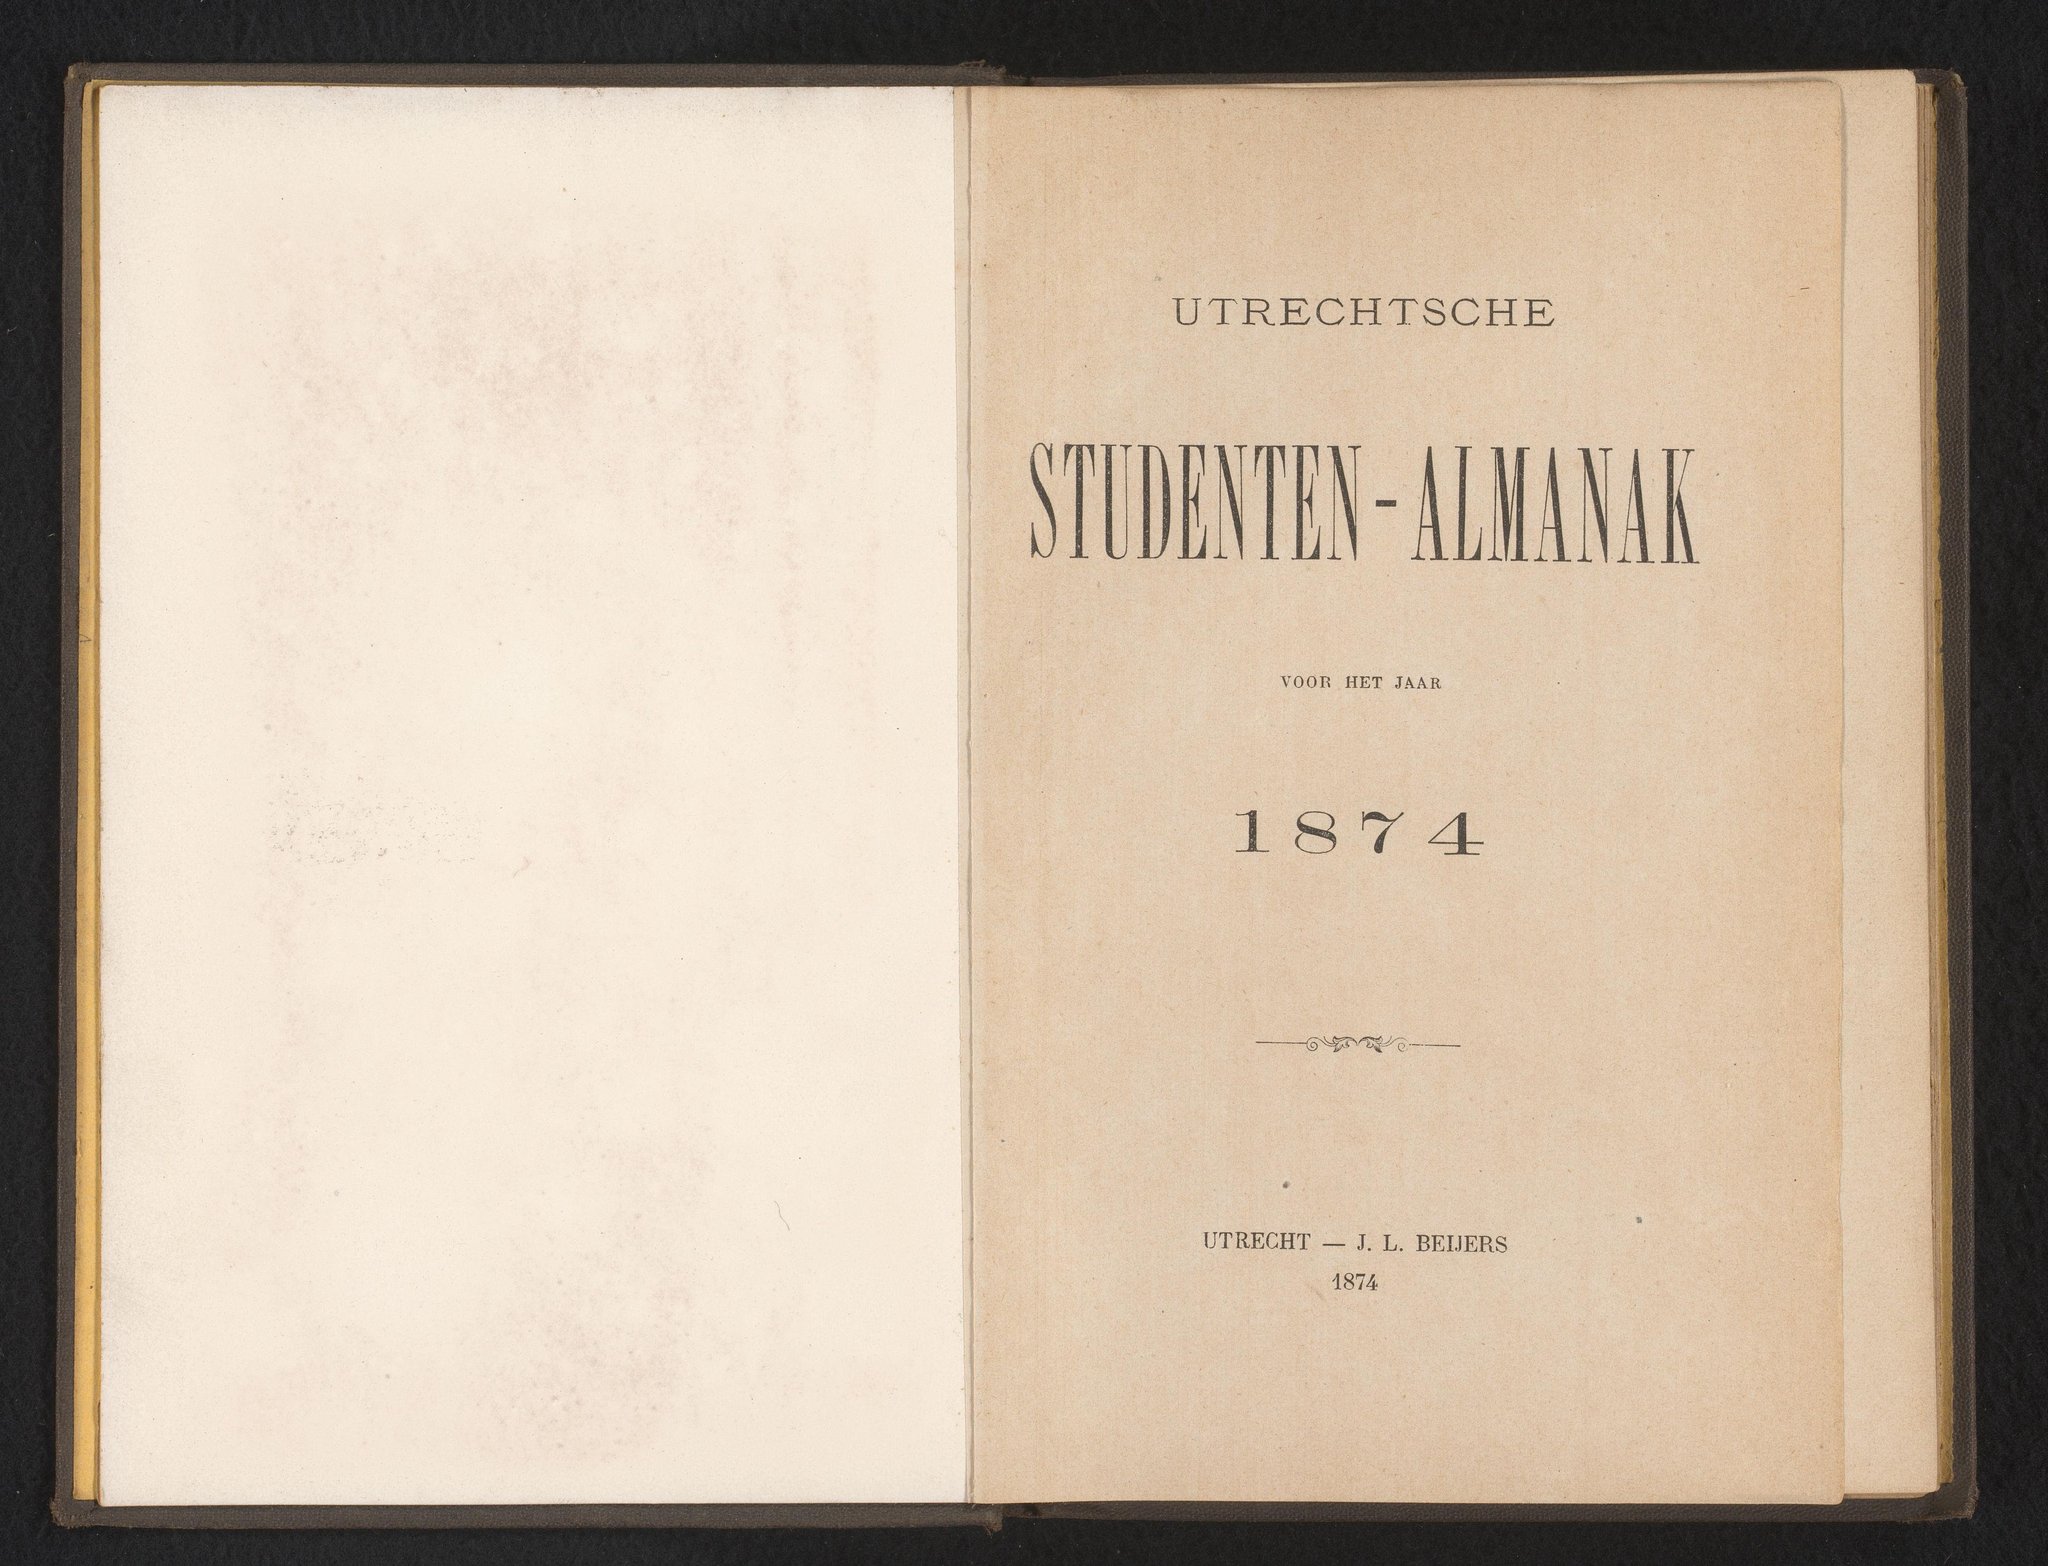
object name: book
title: Utrechtsche studenten-almanak voor het jaar 1874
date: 1874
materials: cardboard, leather, linen, paper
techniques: albumen print, letterpress printing, lithograph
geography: utrecht